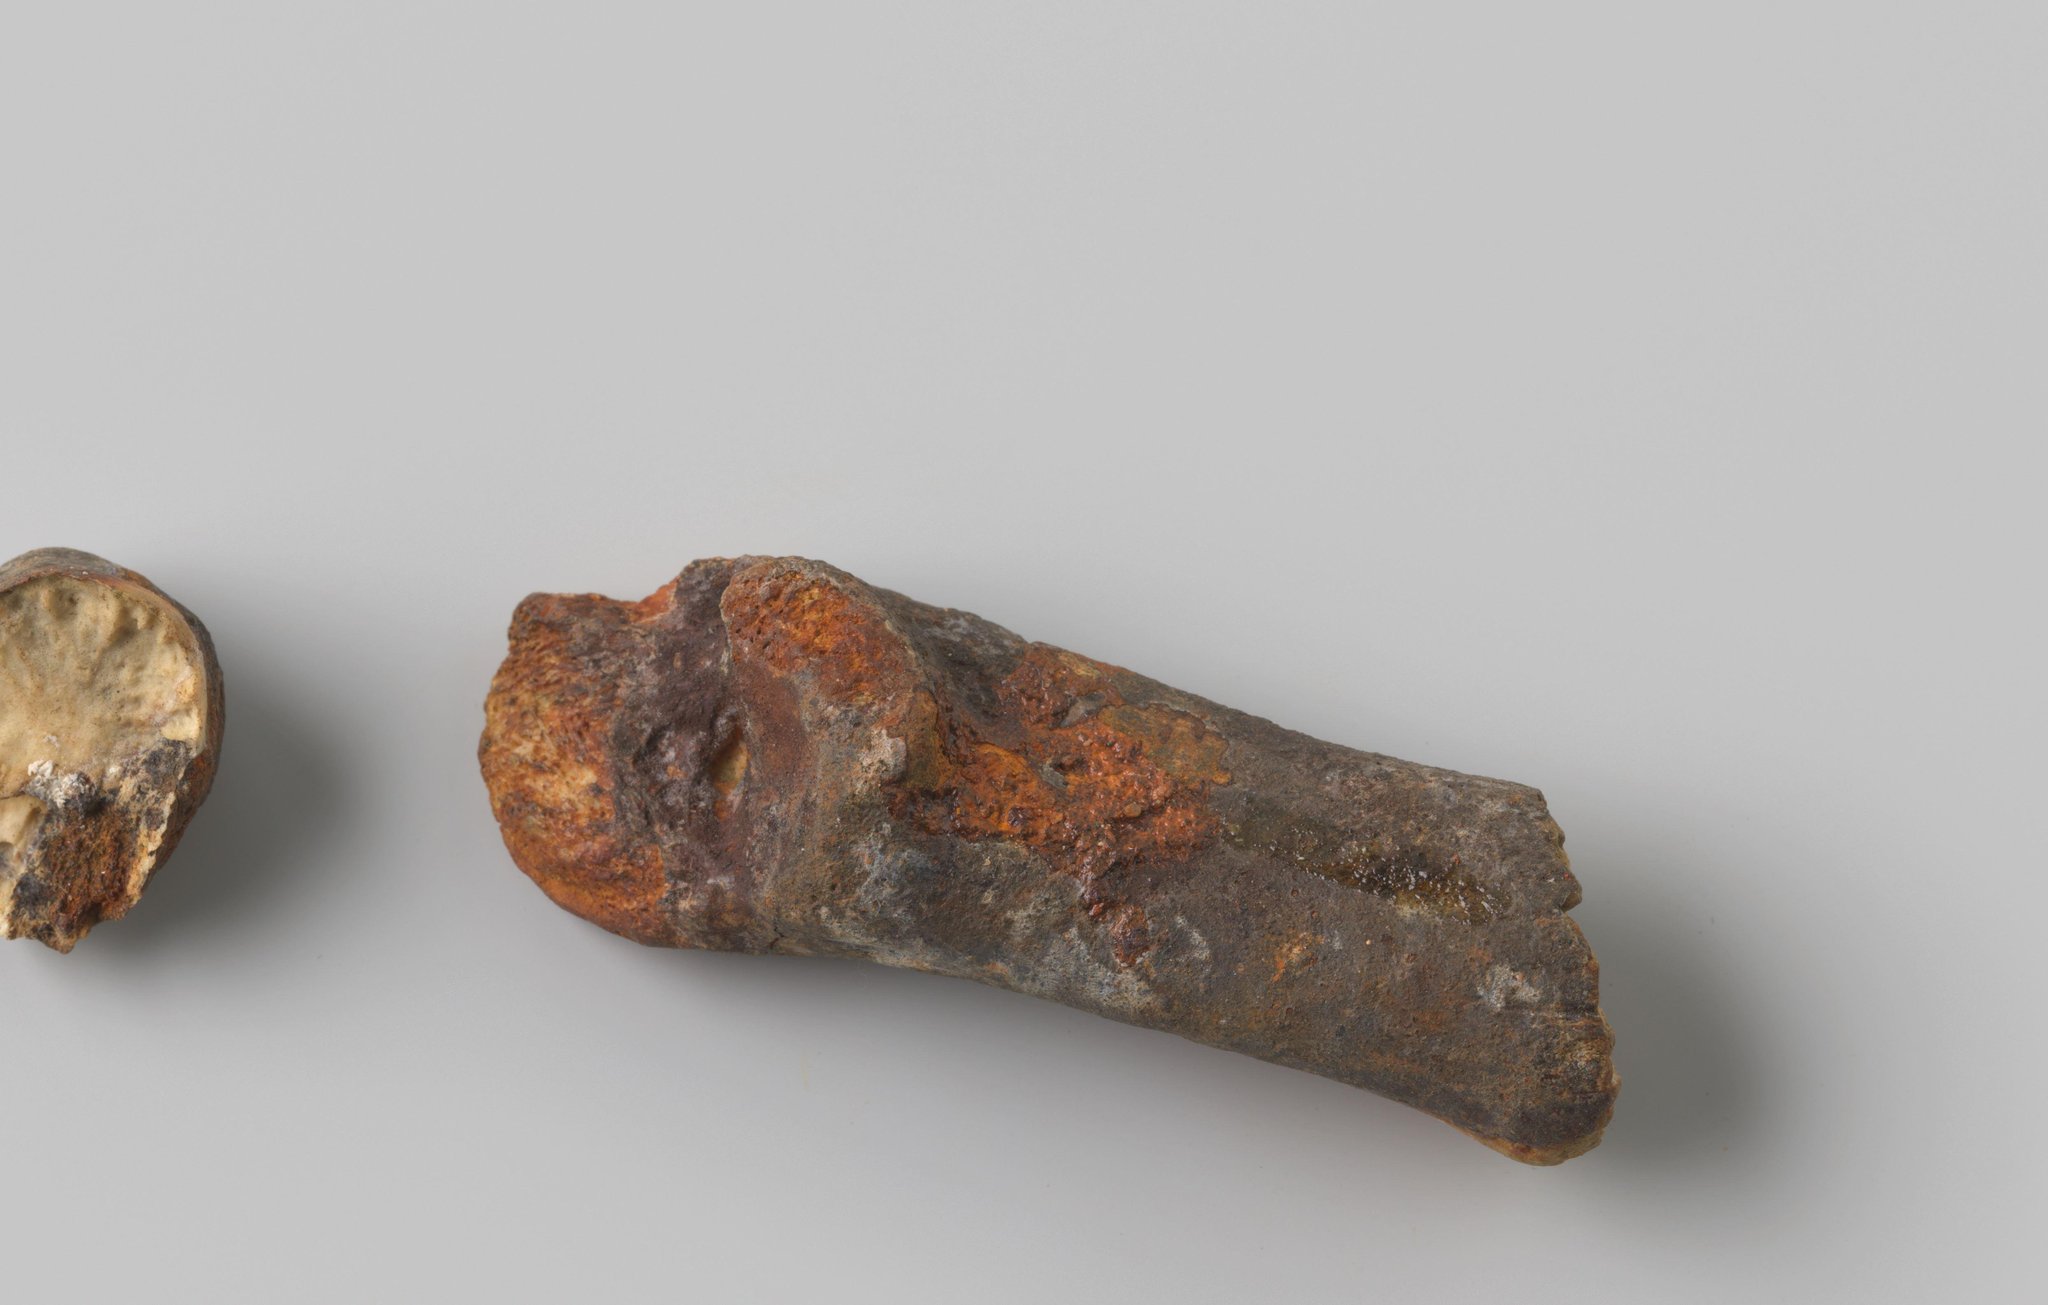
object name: bone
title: Fragmenten hielbot van een varken uit het wrak van de Oost-Indiëvaarder Hollandia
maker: niet van toepassing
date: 1700-1743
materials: bone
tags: verenigde oostindische compagnie, hollandia (schip), annet